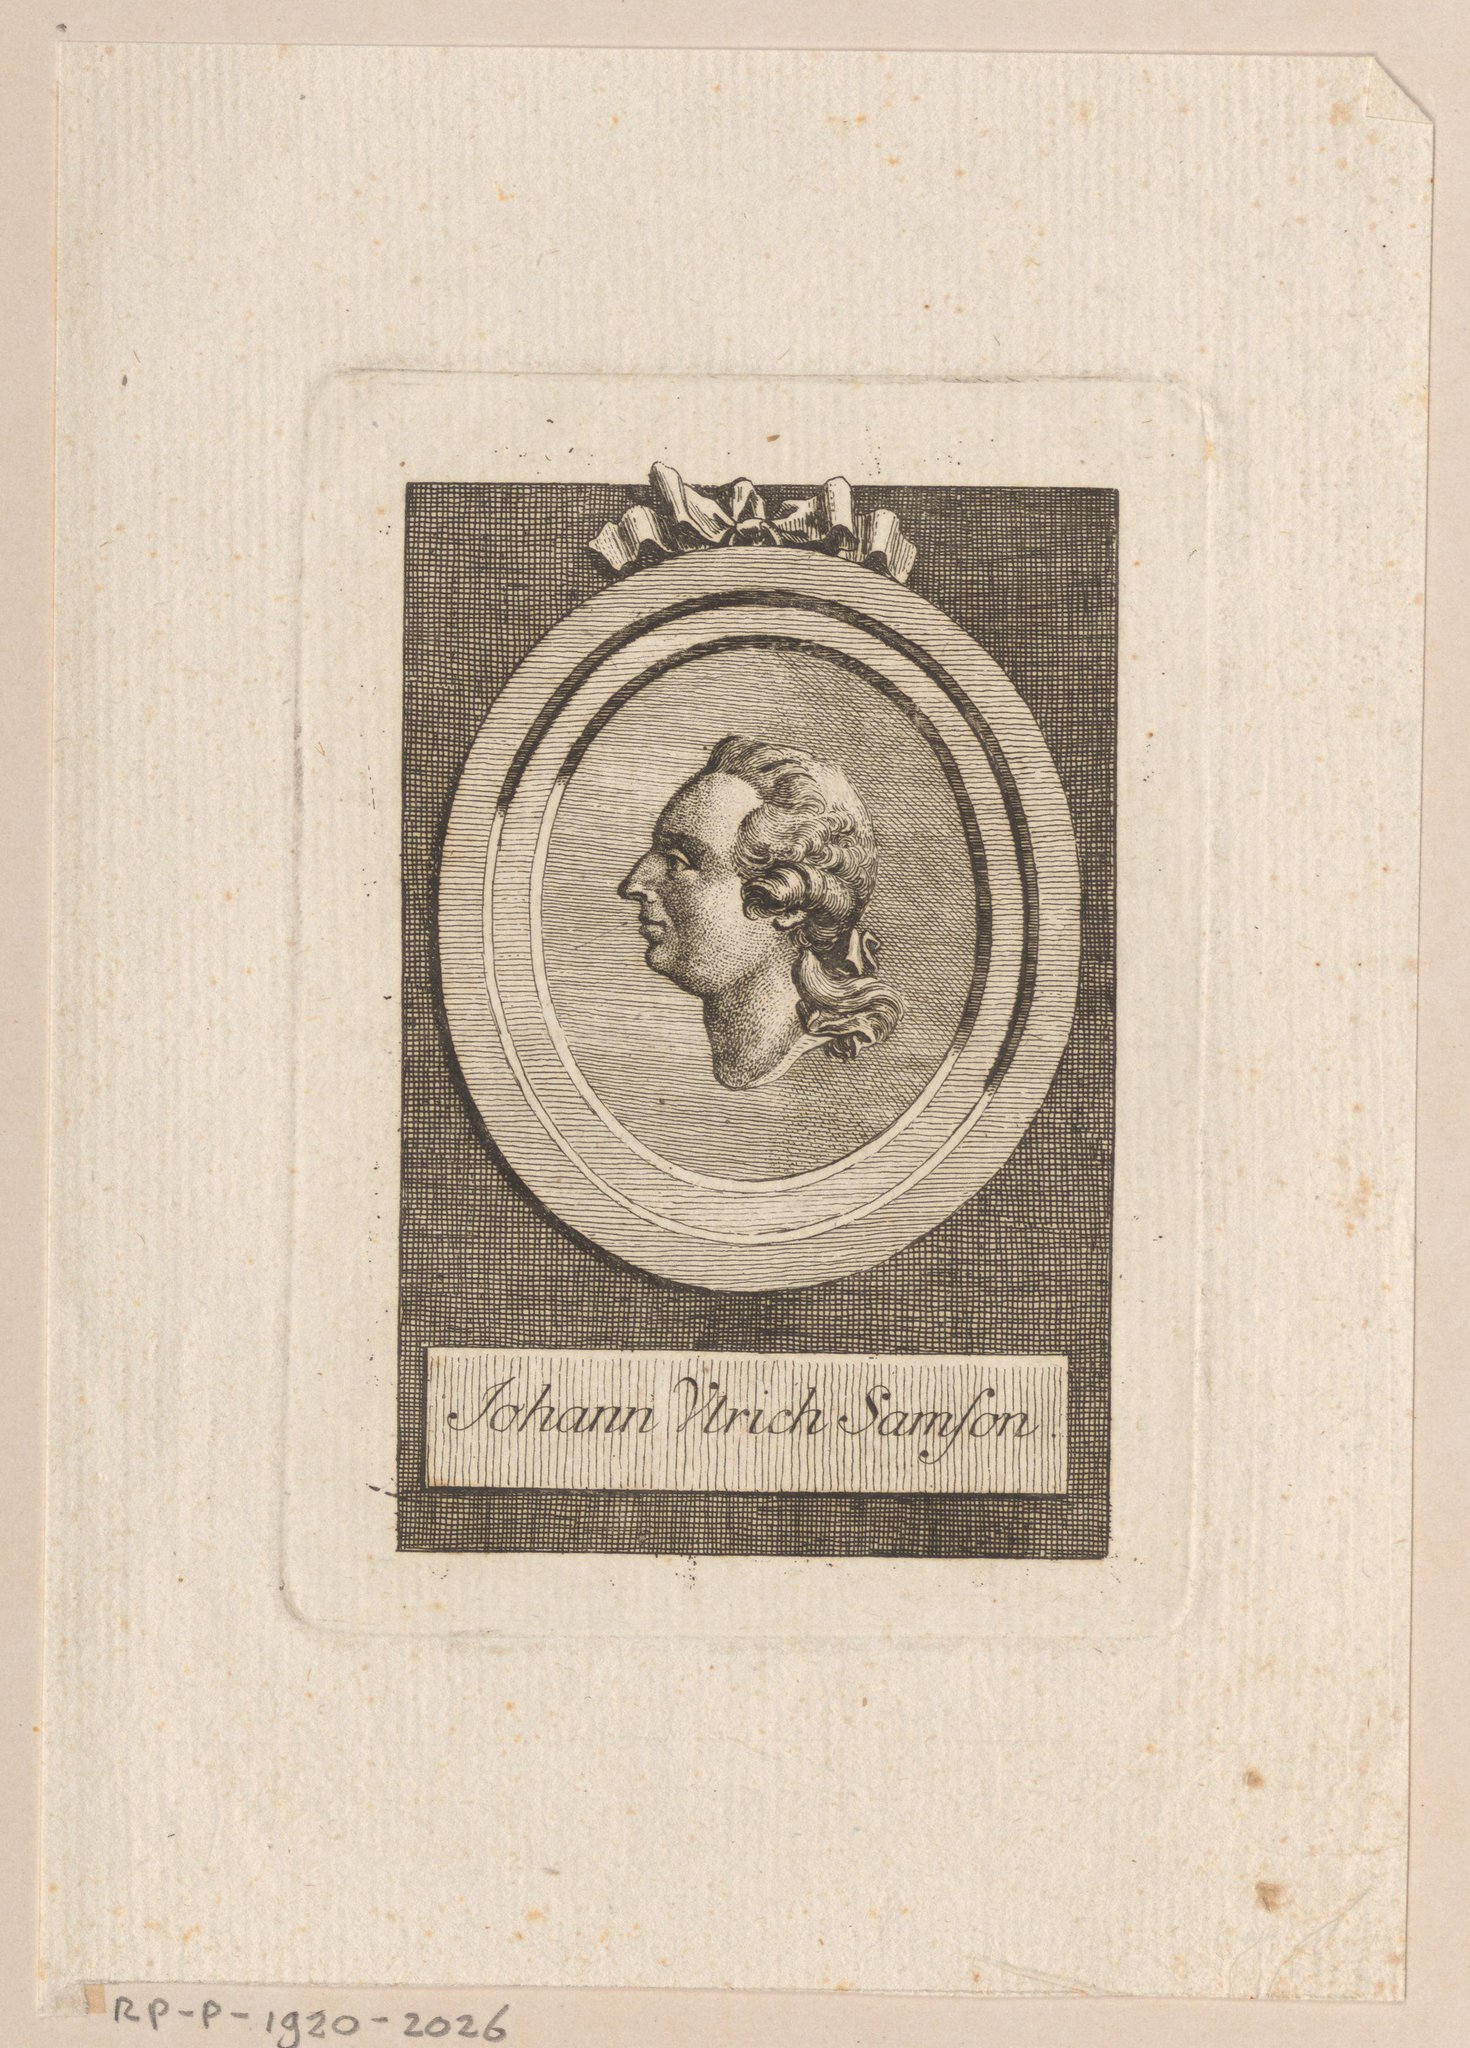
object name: print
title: Portret van Johann Ulrich Samson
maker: Anonymous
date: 1774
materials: paper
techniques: engraving, etching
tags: johann ulrich samson, historical persons, portrait, self-portrait of artist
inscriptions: collector's mark: Lugt 2228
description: Prent waarschijnlijk uit: Füssli, Johann Caspar. Geschichte der besten Künstler in der Schweitz: Nebst ihren Bildnissen. Zürich: Orell, Geßner, Füßli & Co, 1774, dl. 4.